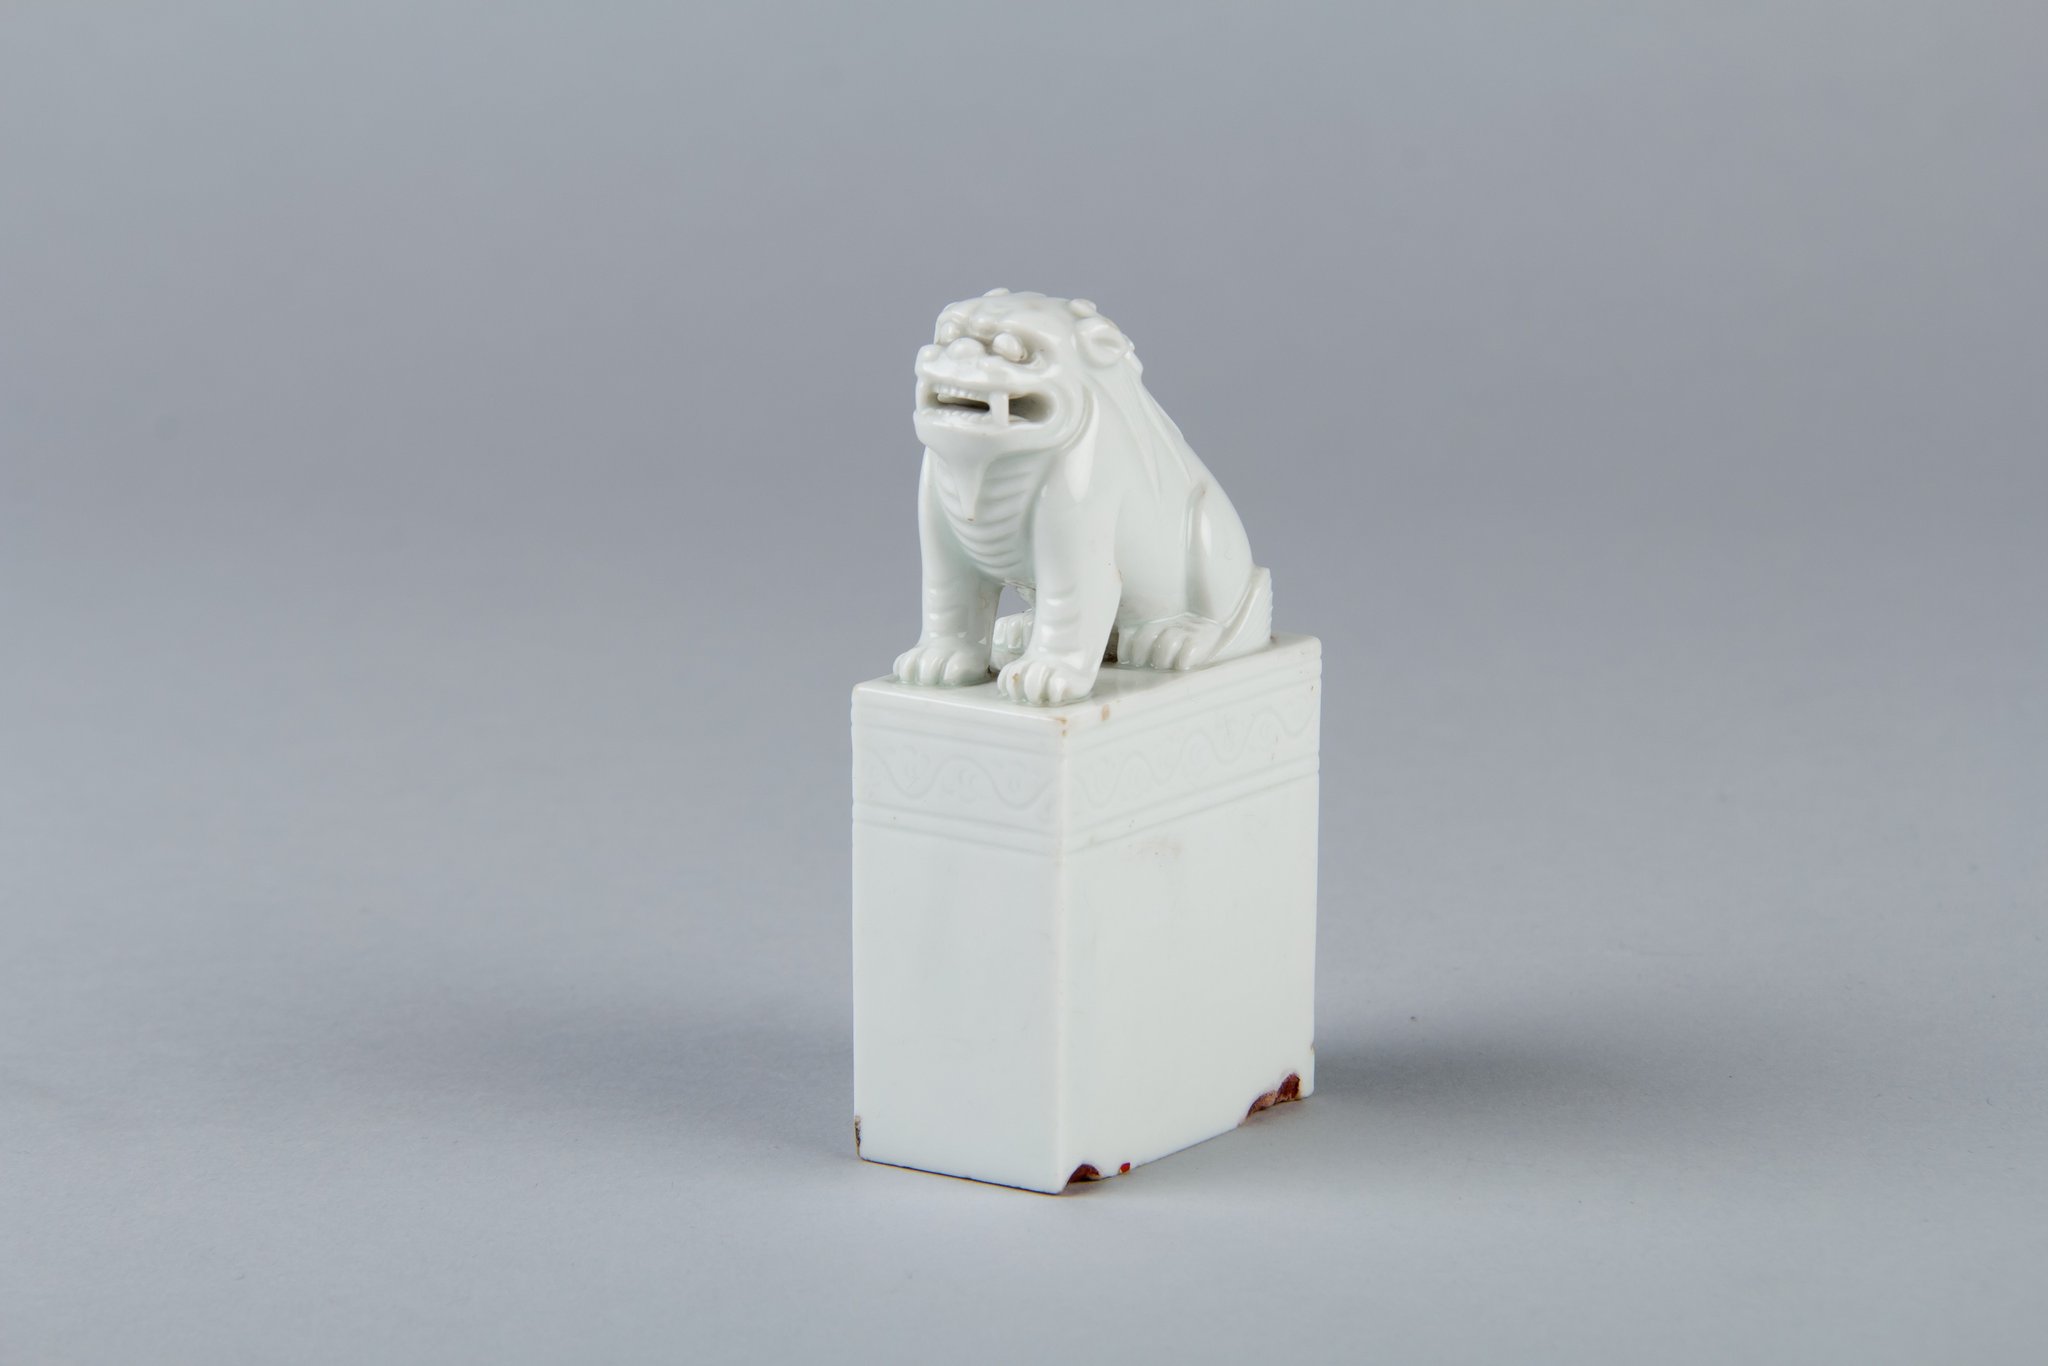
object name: seal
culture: chinese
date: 1644-1911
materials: glaze, porcelain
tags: animals